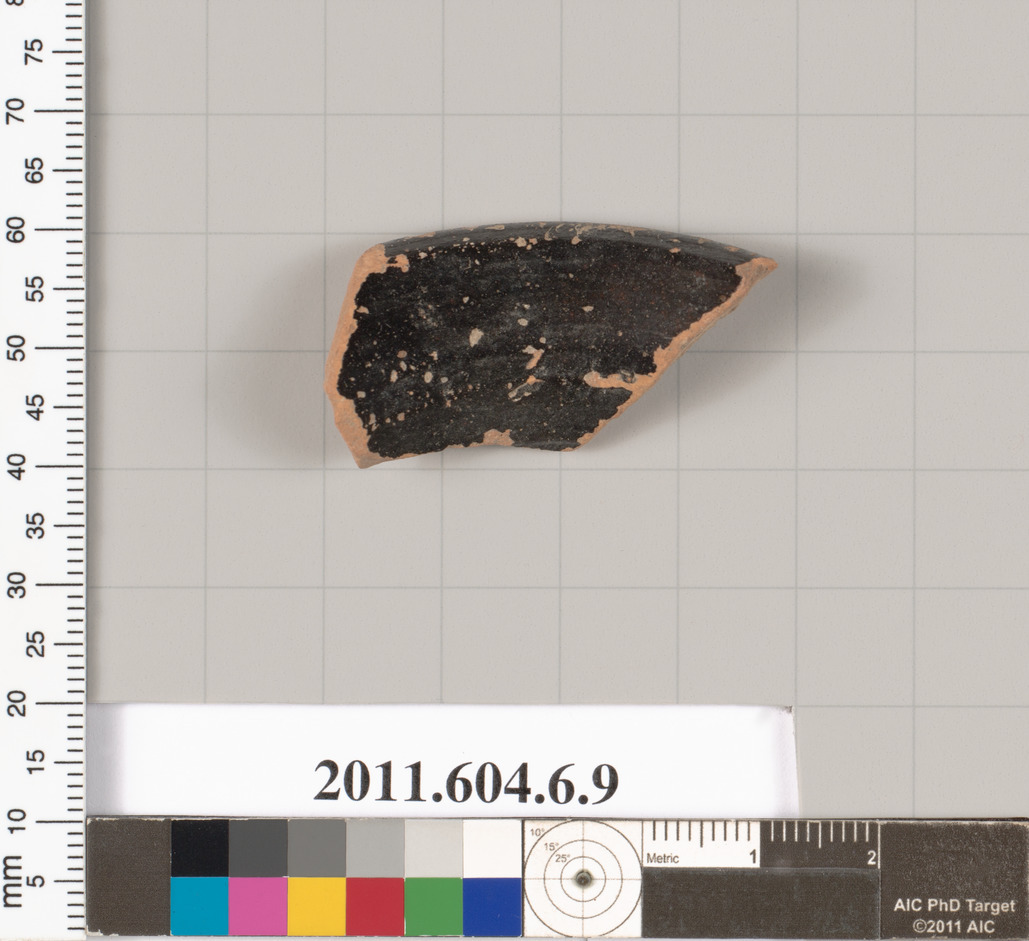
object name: undetermined open shape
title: Terracotta rim fragment of an open shape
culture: greek, attic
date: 600-401 BCE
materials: terracotta